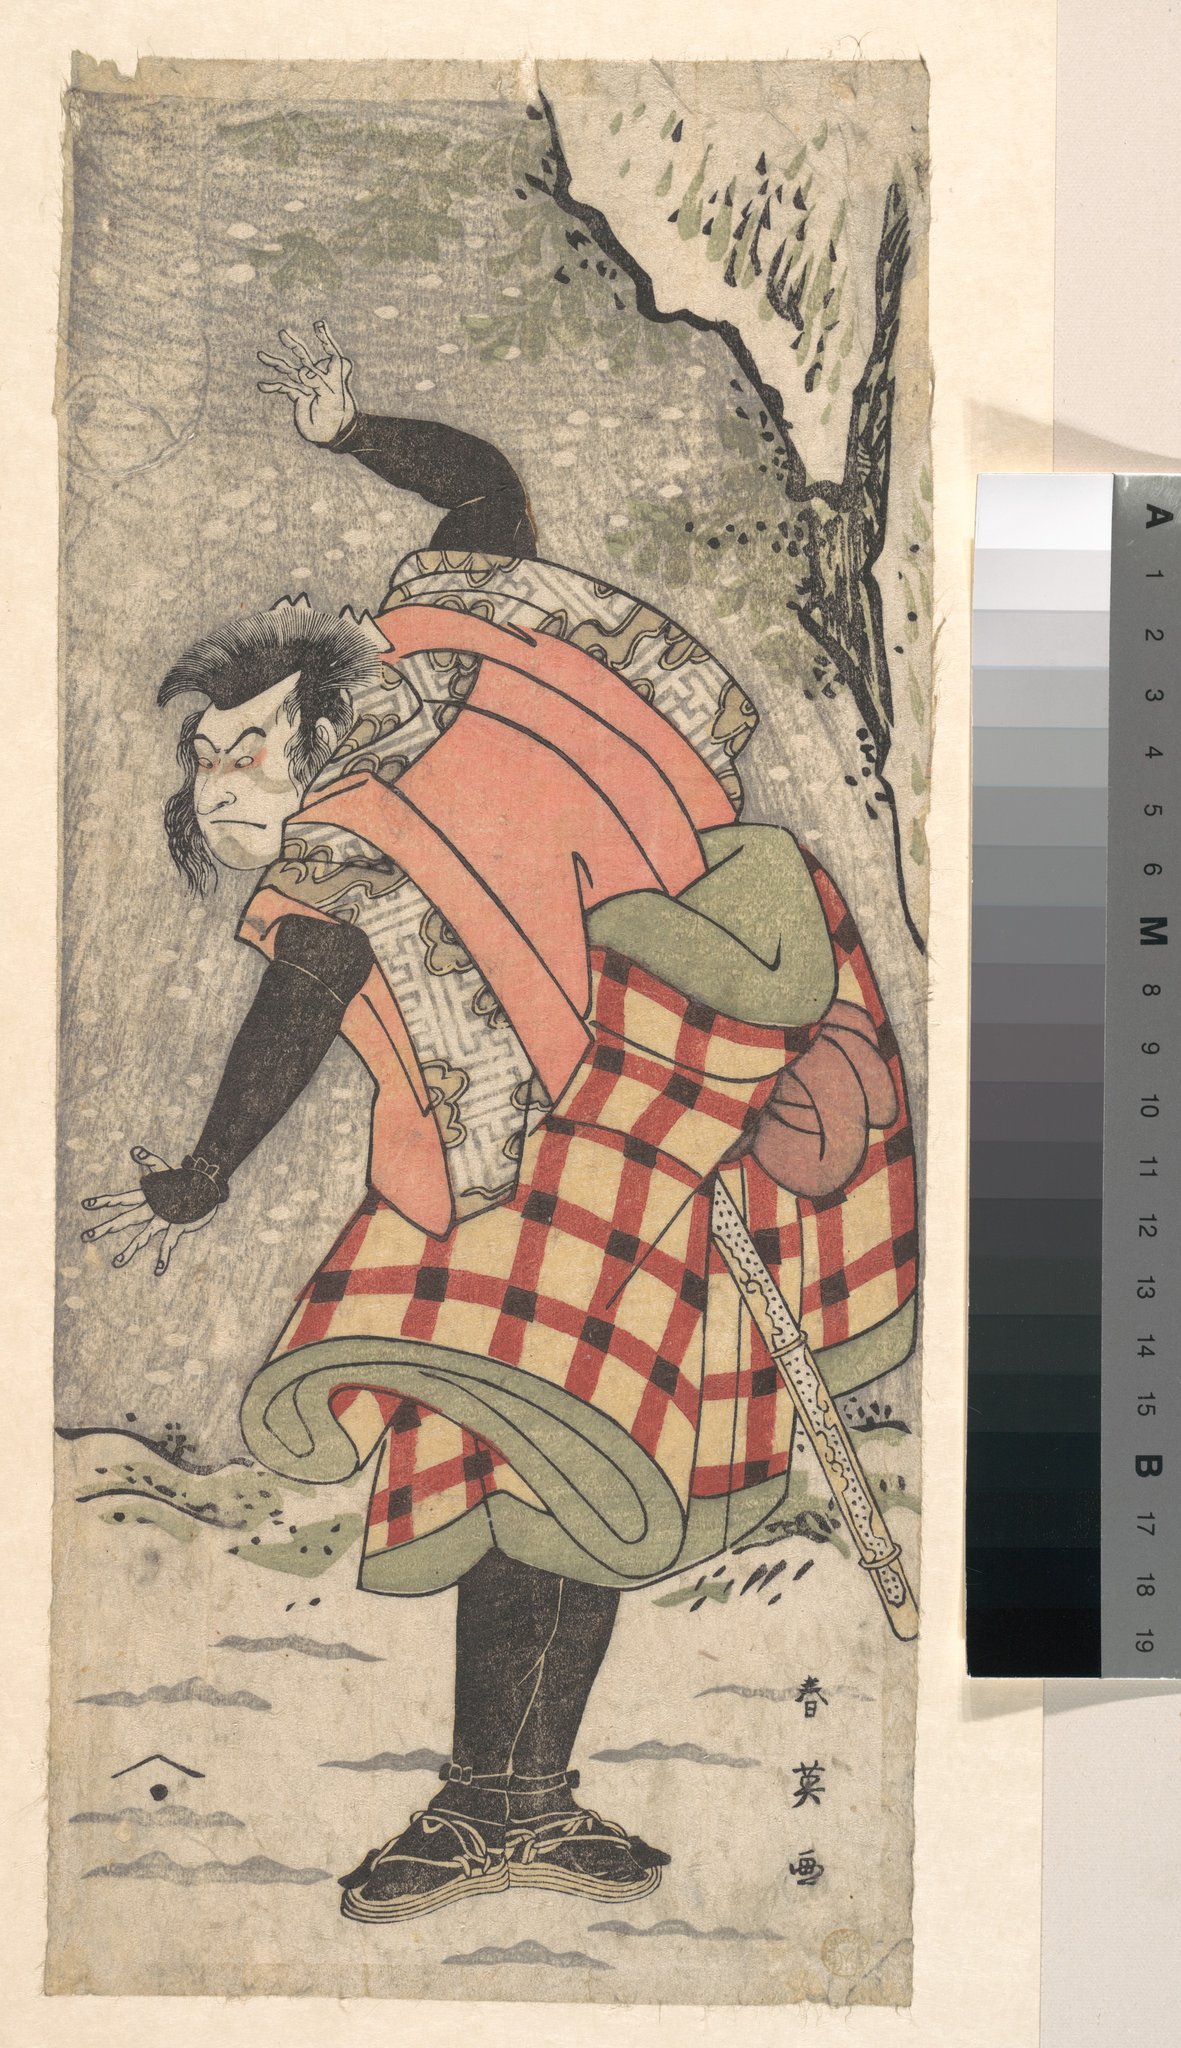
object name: print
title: Unidentified Actor as a Kyokaku Standing at the Foot of a Cliff in a Snow Storm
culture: japanese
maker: katsukawa shun'ei 勝川春英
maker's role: artist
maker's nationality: japanese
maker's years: 1762-1819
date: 1793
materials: ink, paper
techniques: woodblock print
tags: men,actors